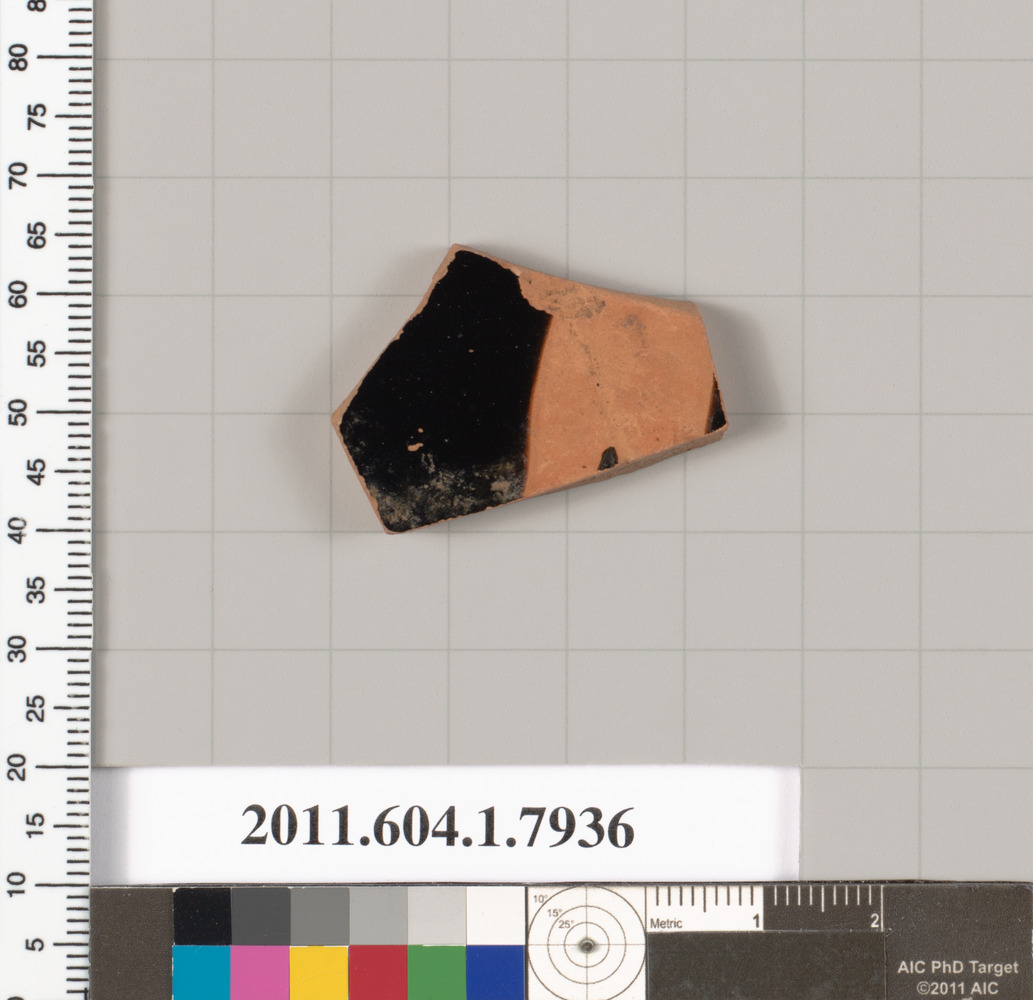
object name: kylix fragment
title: Terracotta fragment of a kylix (drinking cup)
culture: greek, attic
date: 460-450 BCE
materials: terracotta